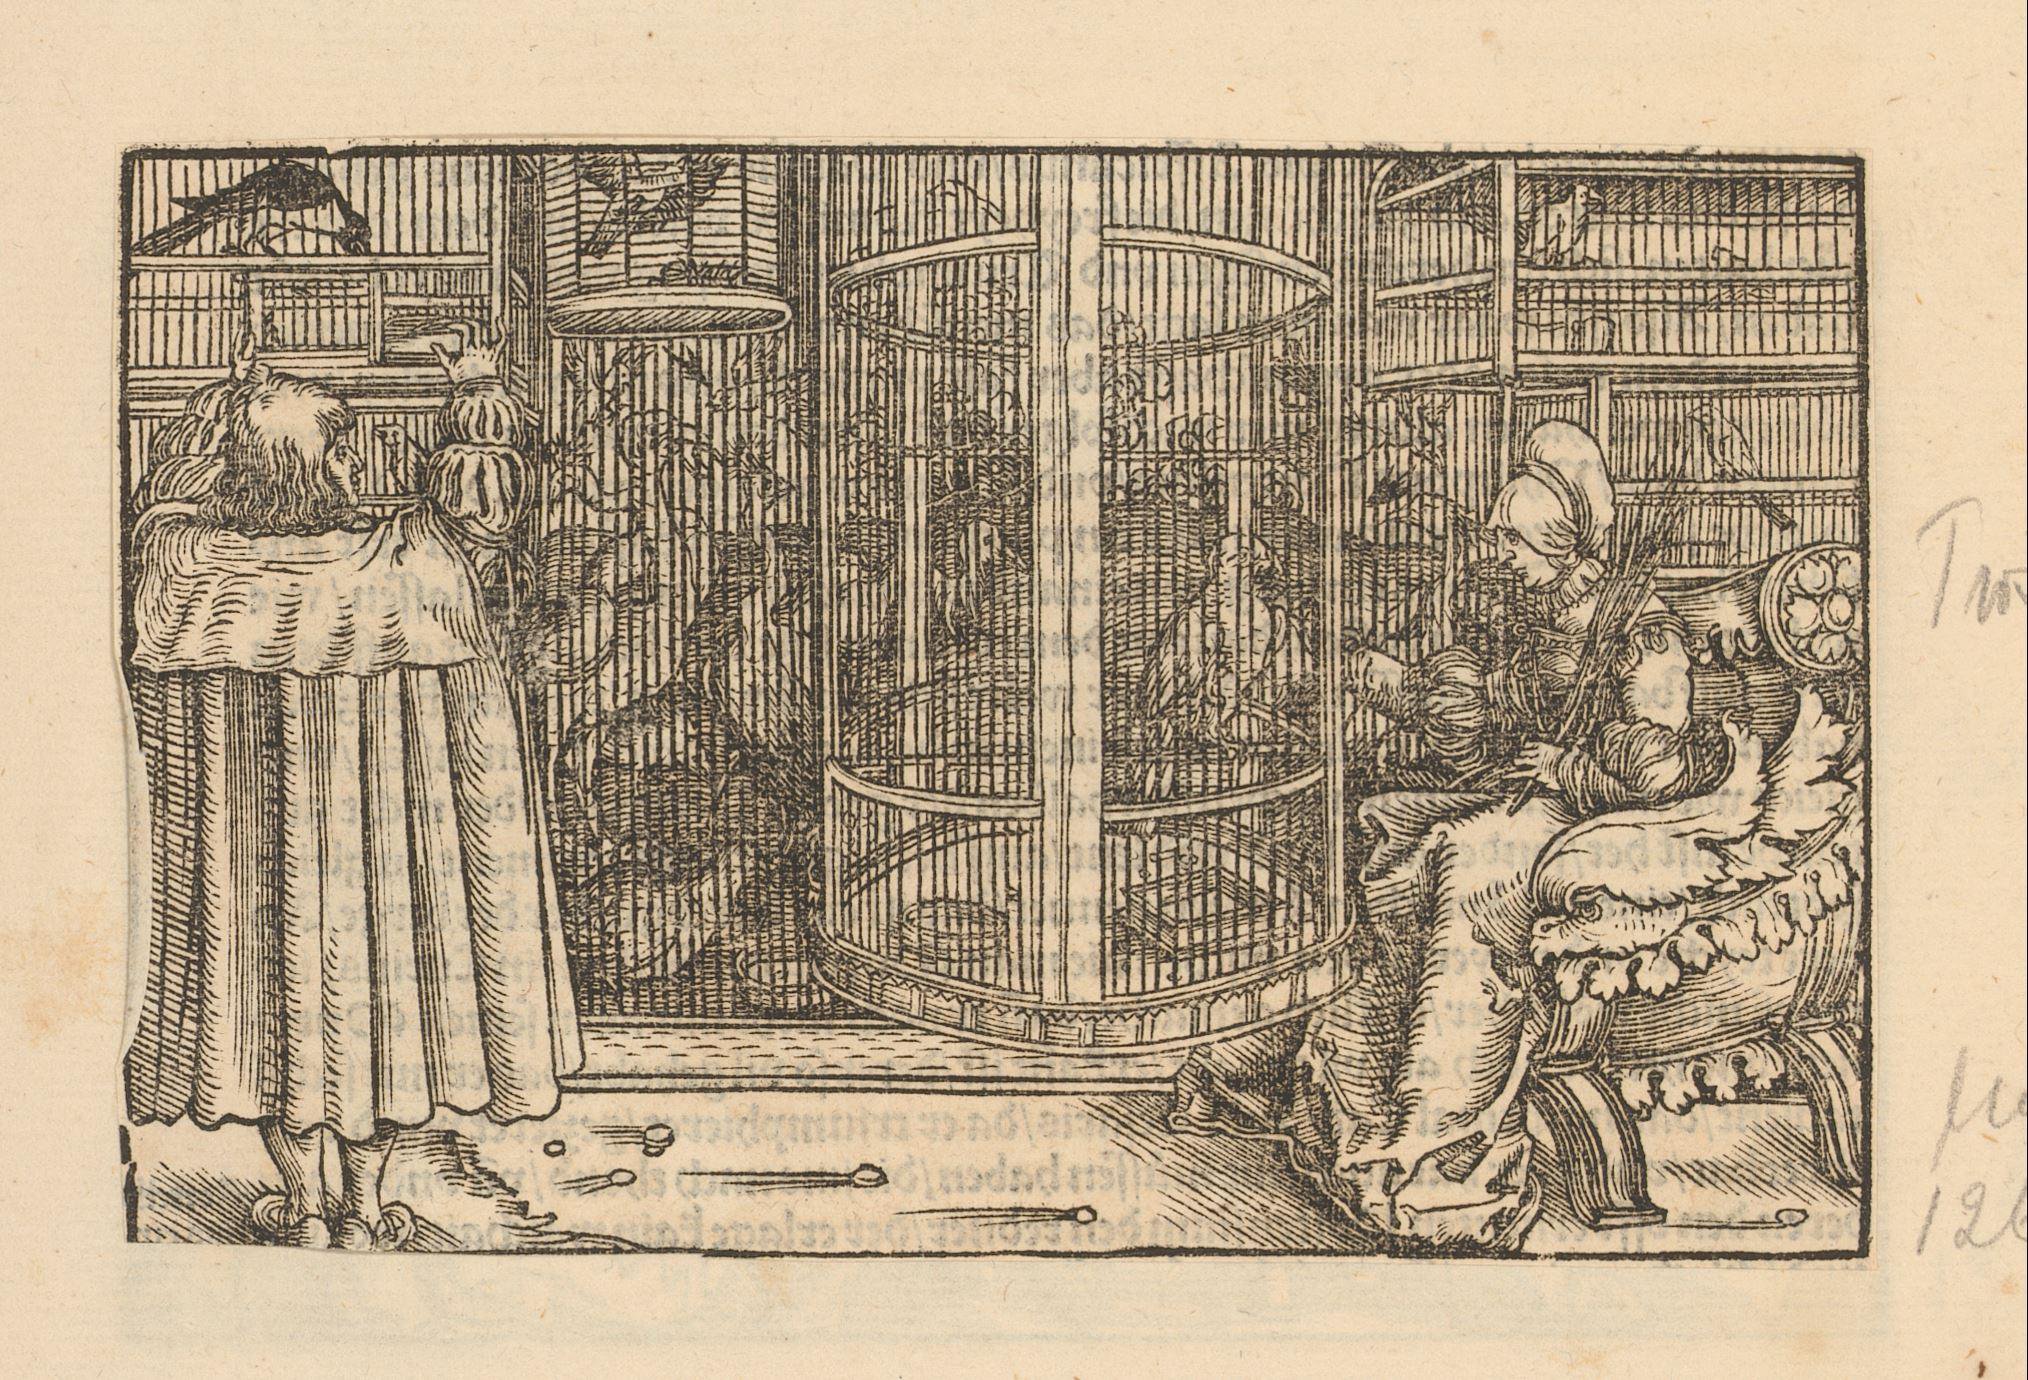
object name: print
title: Volières en een stel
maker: Anonymous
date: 1514-1532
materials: paper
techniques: letterpress printing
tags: birds in a large cage, aviary, fabulous animals ~ birds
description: Deze prent is gebruikt in: Petrarca, Francesco. Von der Artzney bayder Glück, des guten und widerwertigen: unnd weß sich ain yeder inn Gelück und Unglück halten sol (...). Augsburg: Heinrich Steiner, 1532. Deze uitgave is ook bekend onder de titel 'Trostspiegel in Glück und Unglück'.